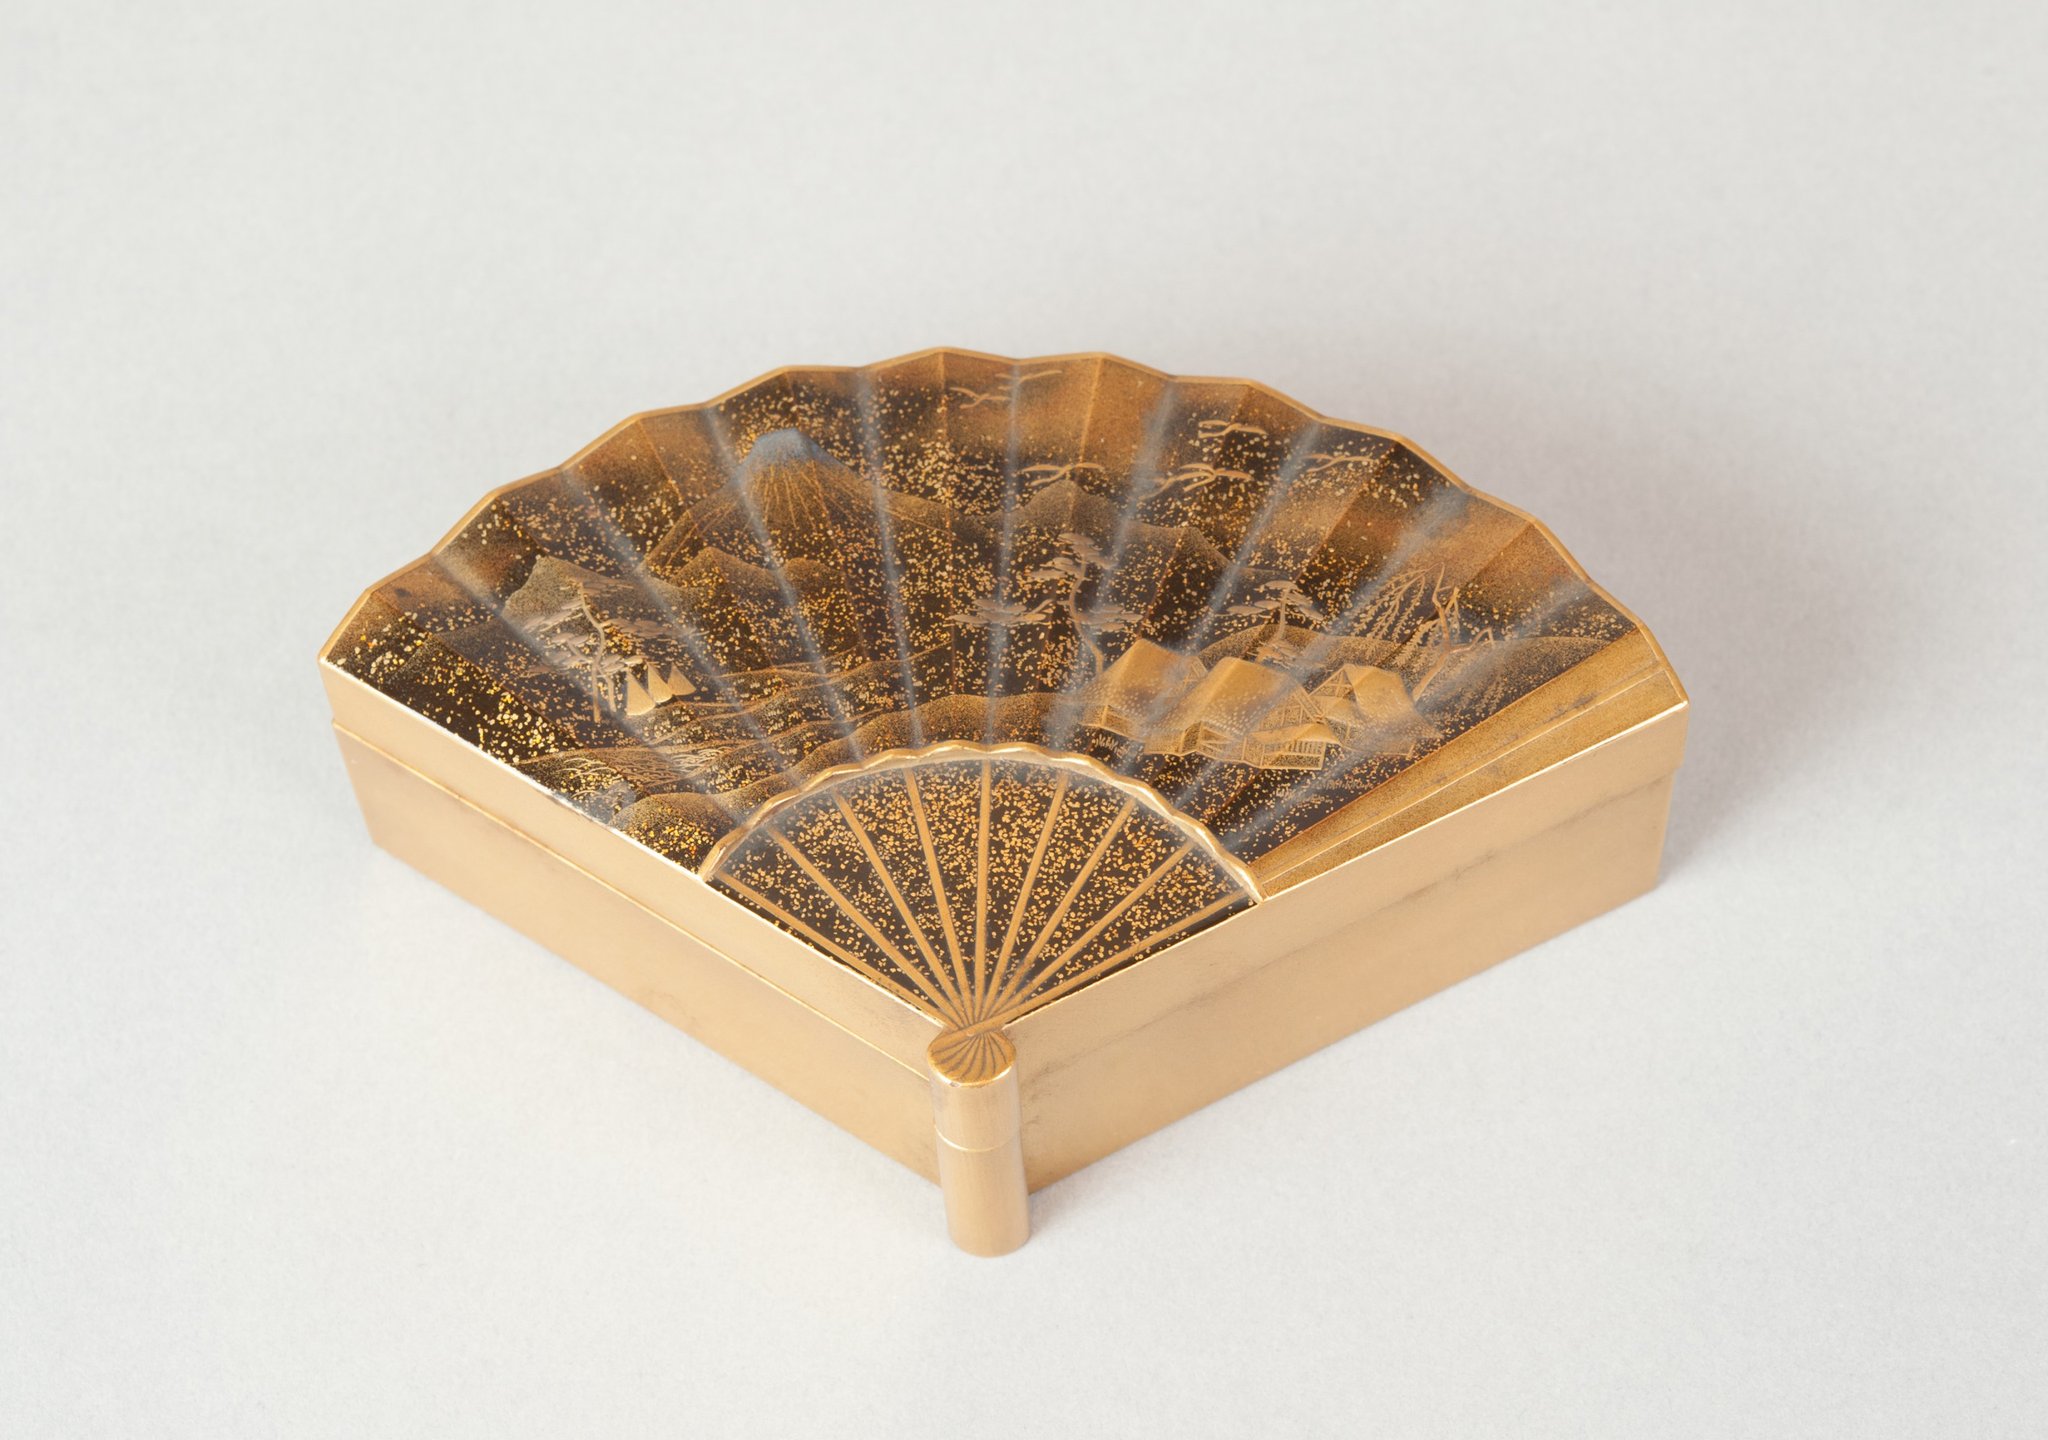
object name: box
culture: japanese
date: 1801-1900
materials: gold, lacquer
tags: houses,volcanoes